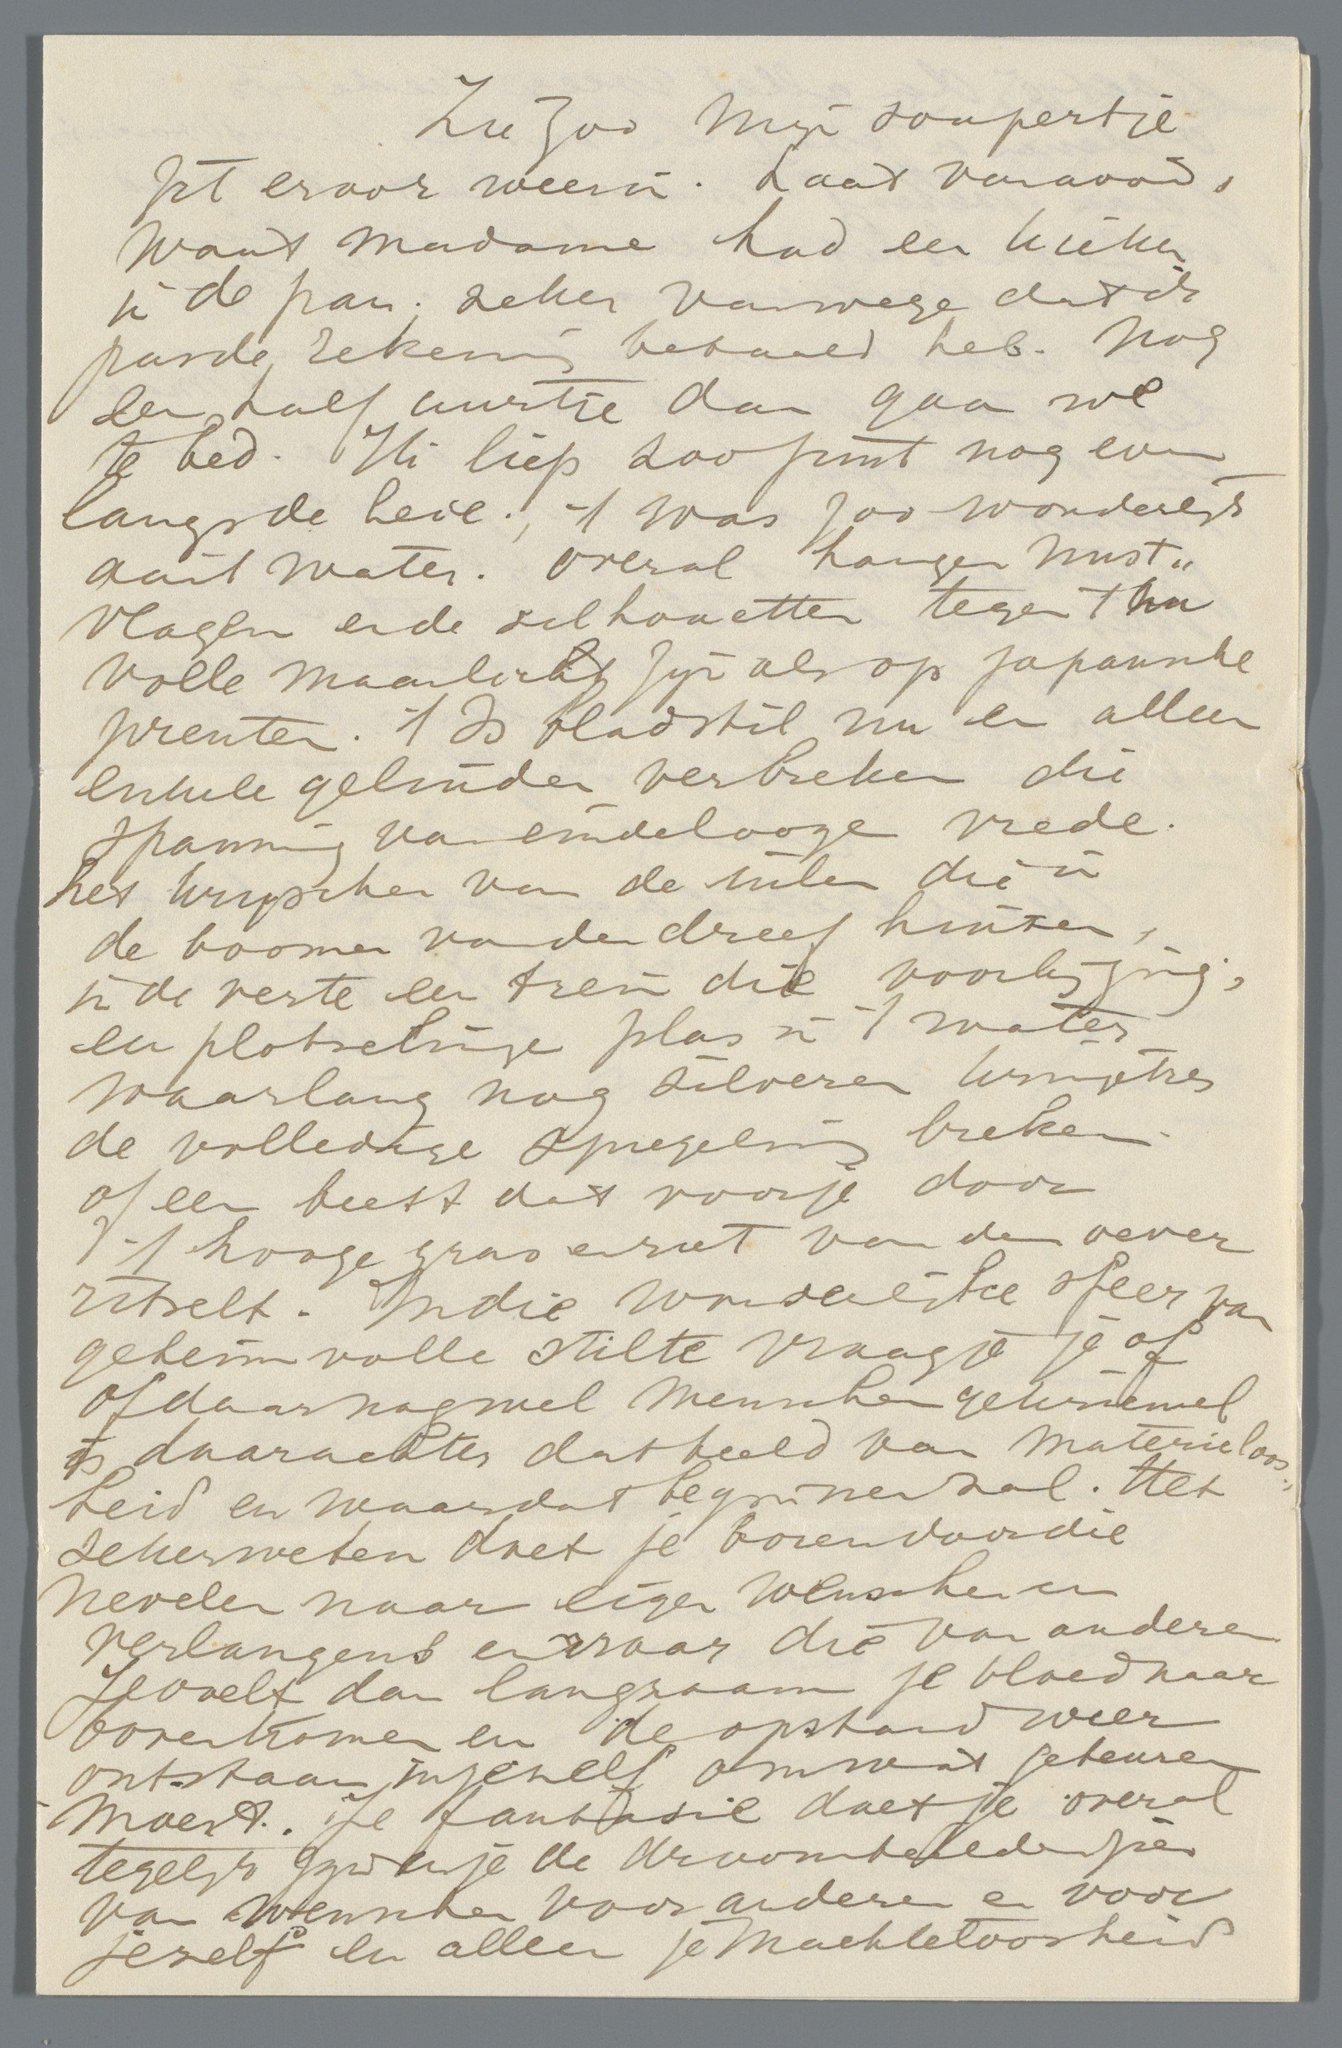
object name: letter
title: Brief aan Jan Ponstijn en Henriëtte Johanna Petronella van Hilten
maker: leo gestel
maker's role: draughtsman, print maker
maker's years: 1881-1941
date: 1925-1927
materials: ink, paper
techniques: pen, writing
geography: drongen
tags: henriëtte johanna petronella ponstijn-van hilten, amsterdam, print maker, draughtsman, jan petrus ponstijn, matthieu wiegman, zeist, the arts; artists, landscapes with waters, waterscapes, seascapes (in the temperate zone)